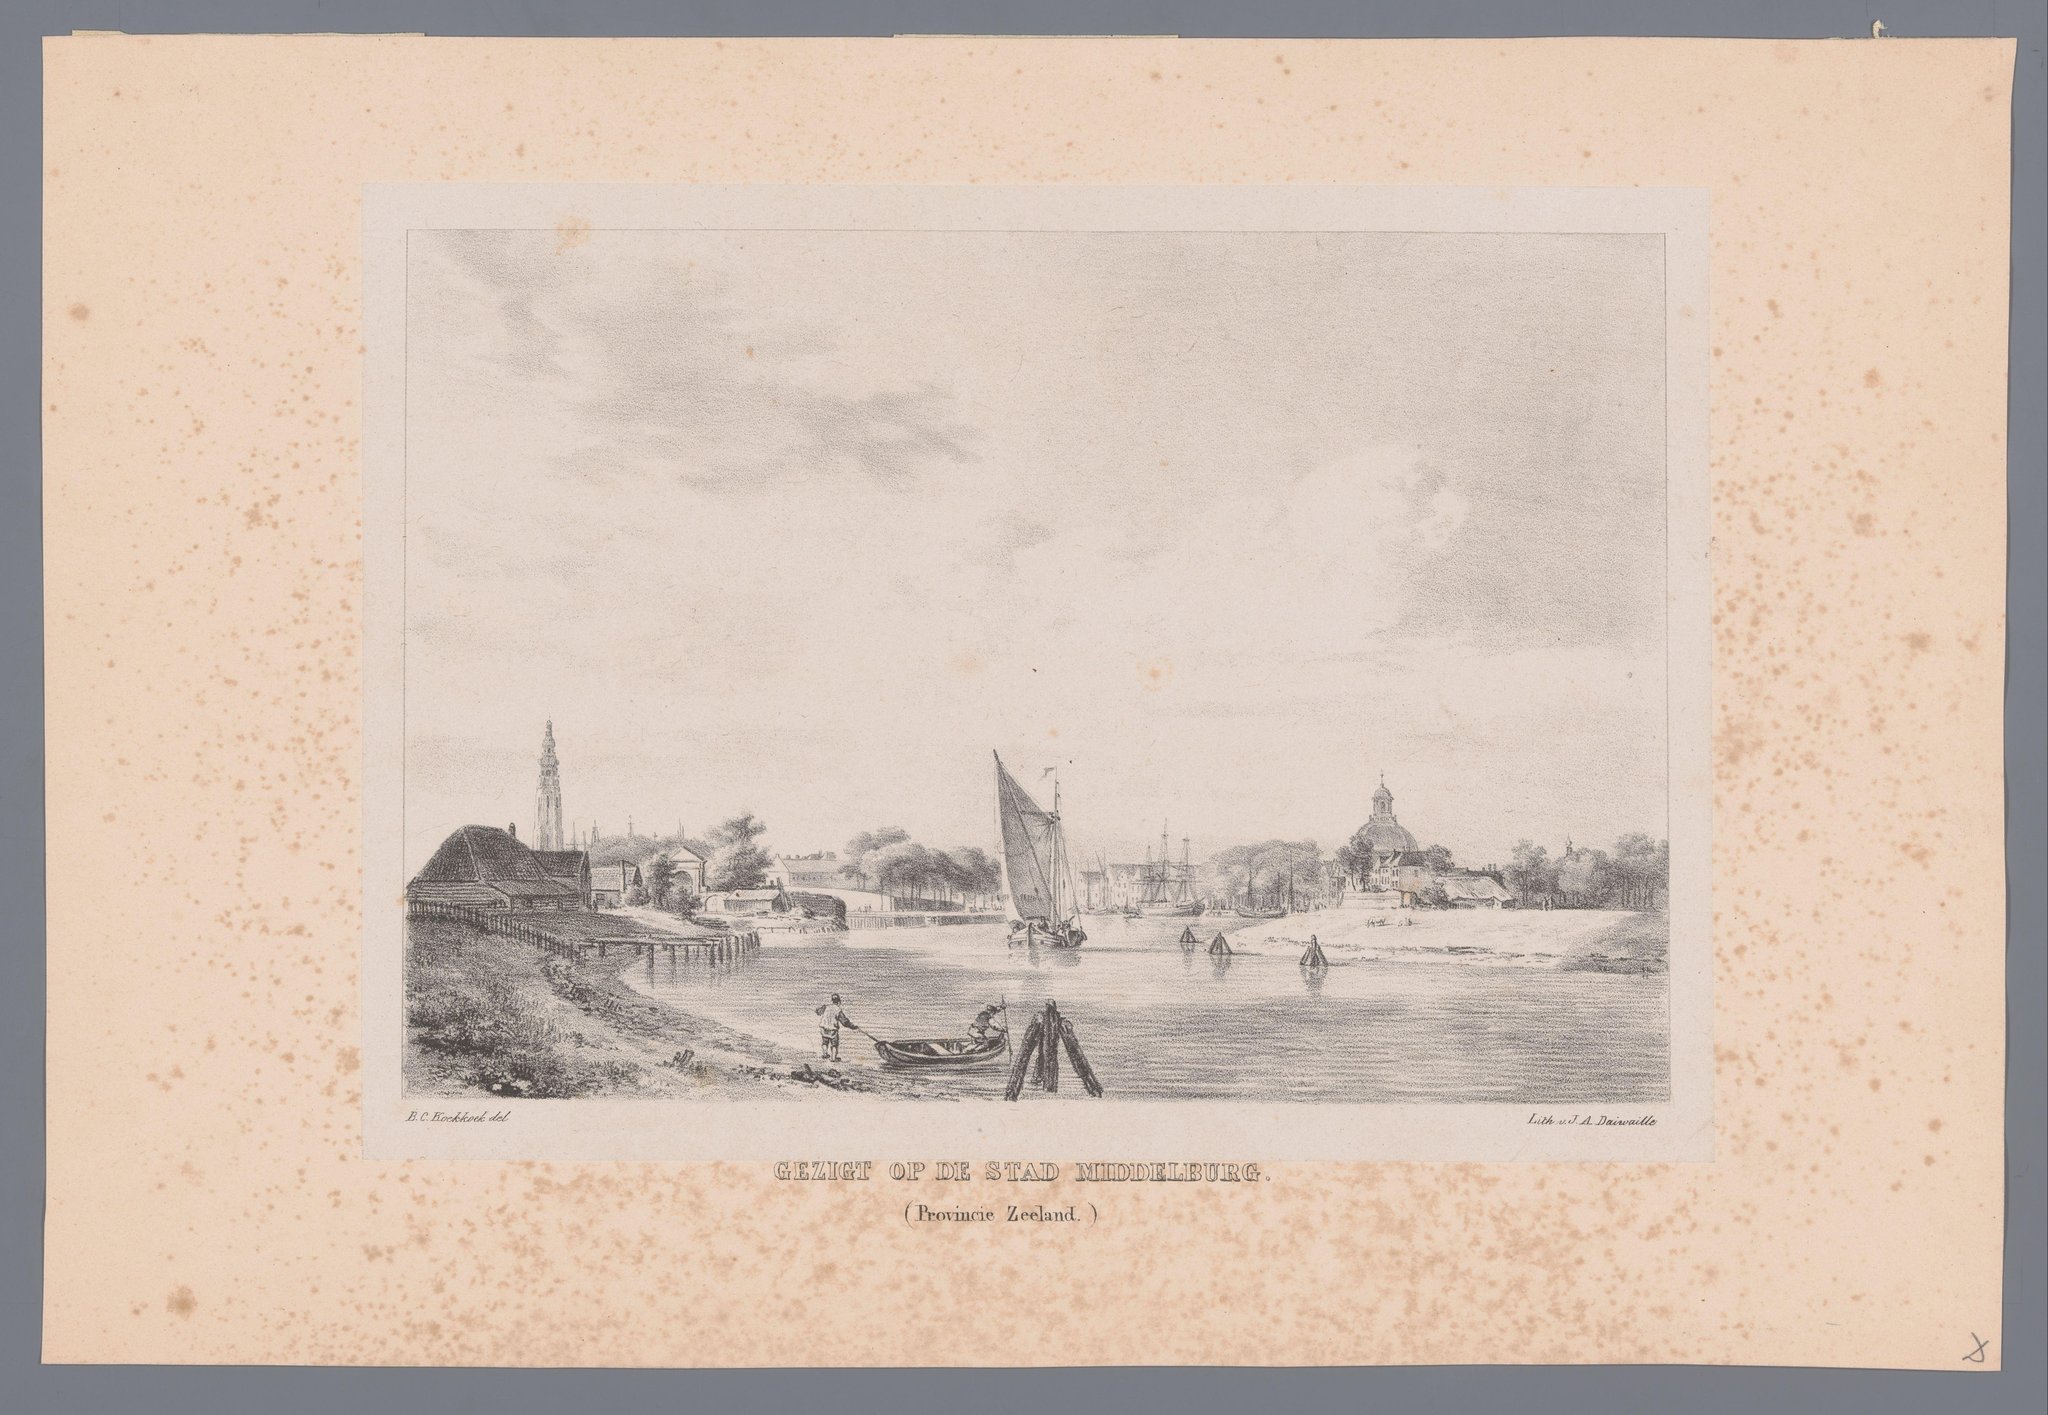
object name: print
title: Gezigt op de stad Middelburg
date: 1831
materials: paper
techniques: lithograph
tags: sailing-ship, sailing-boat, canals, waters (in city), city-view, and landscape with man-made constructions (+ city(-scape) with figures, staffage), middelburg